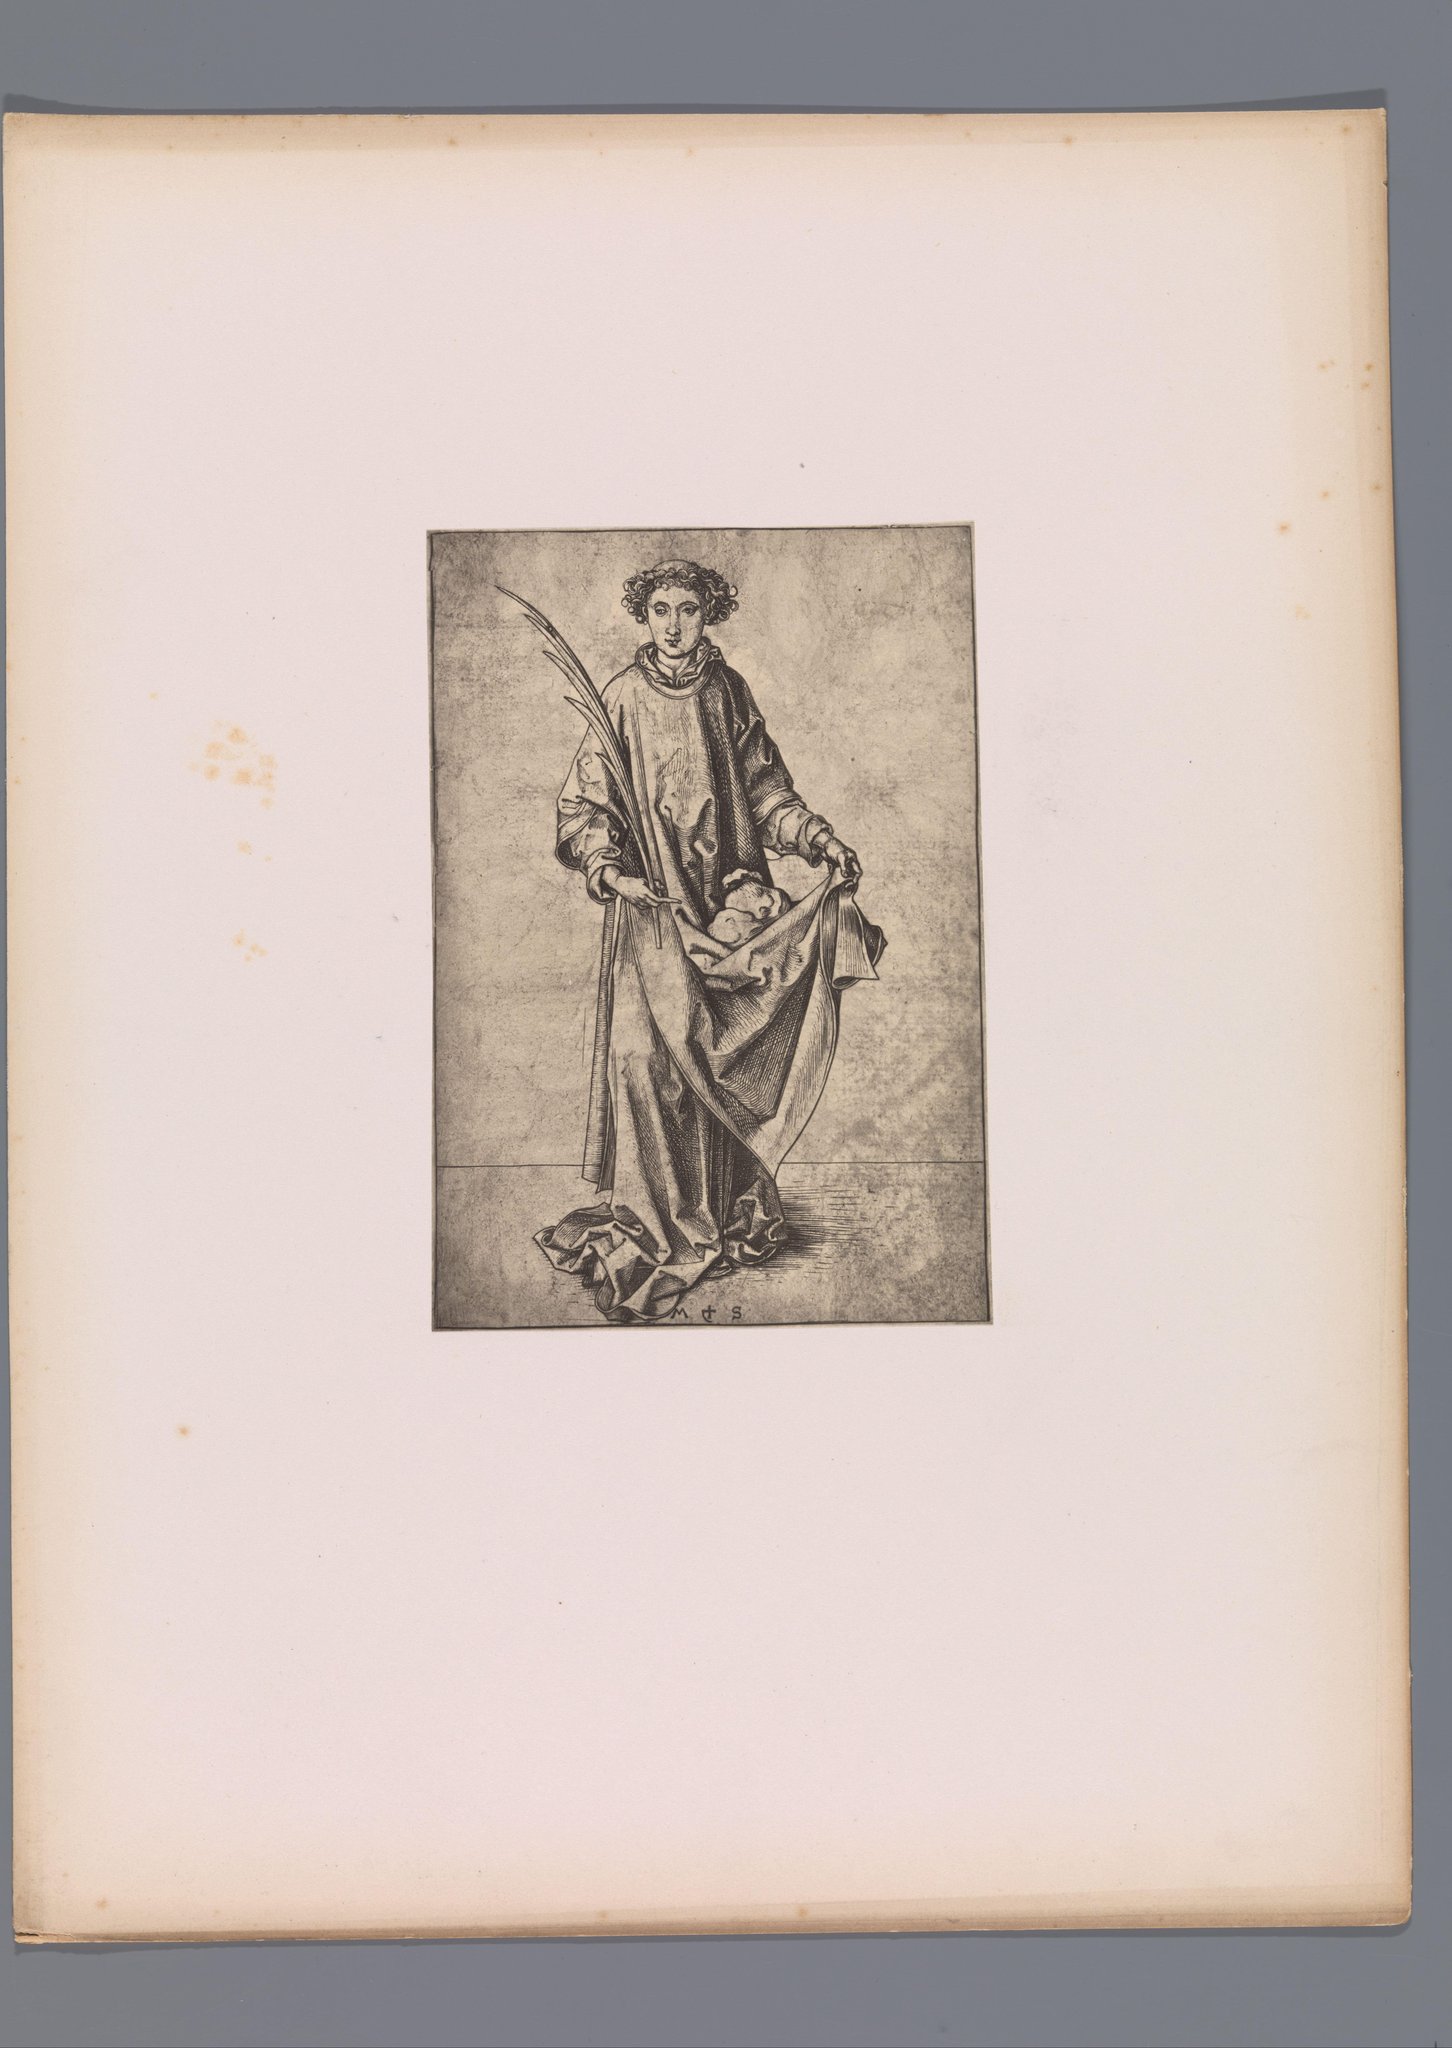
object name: reproduction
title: Reproductie van een prent van de heilige Stefanus door Martin Schongauer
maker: martin schongauer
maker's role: print maker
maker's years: 1430-1491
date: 1867-1872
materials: paper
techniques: woodburytype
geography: brussels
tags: the deacon and (proto)martyr stephen; possible attributes: censer, stones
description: Deze prent maakt deel uit van een omslag met 24 prenten op 24 bladen.